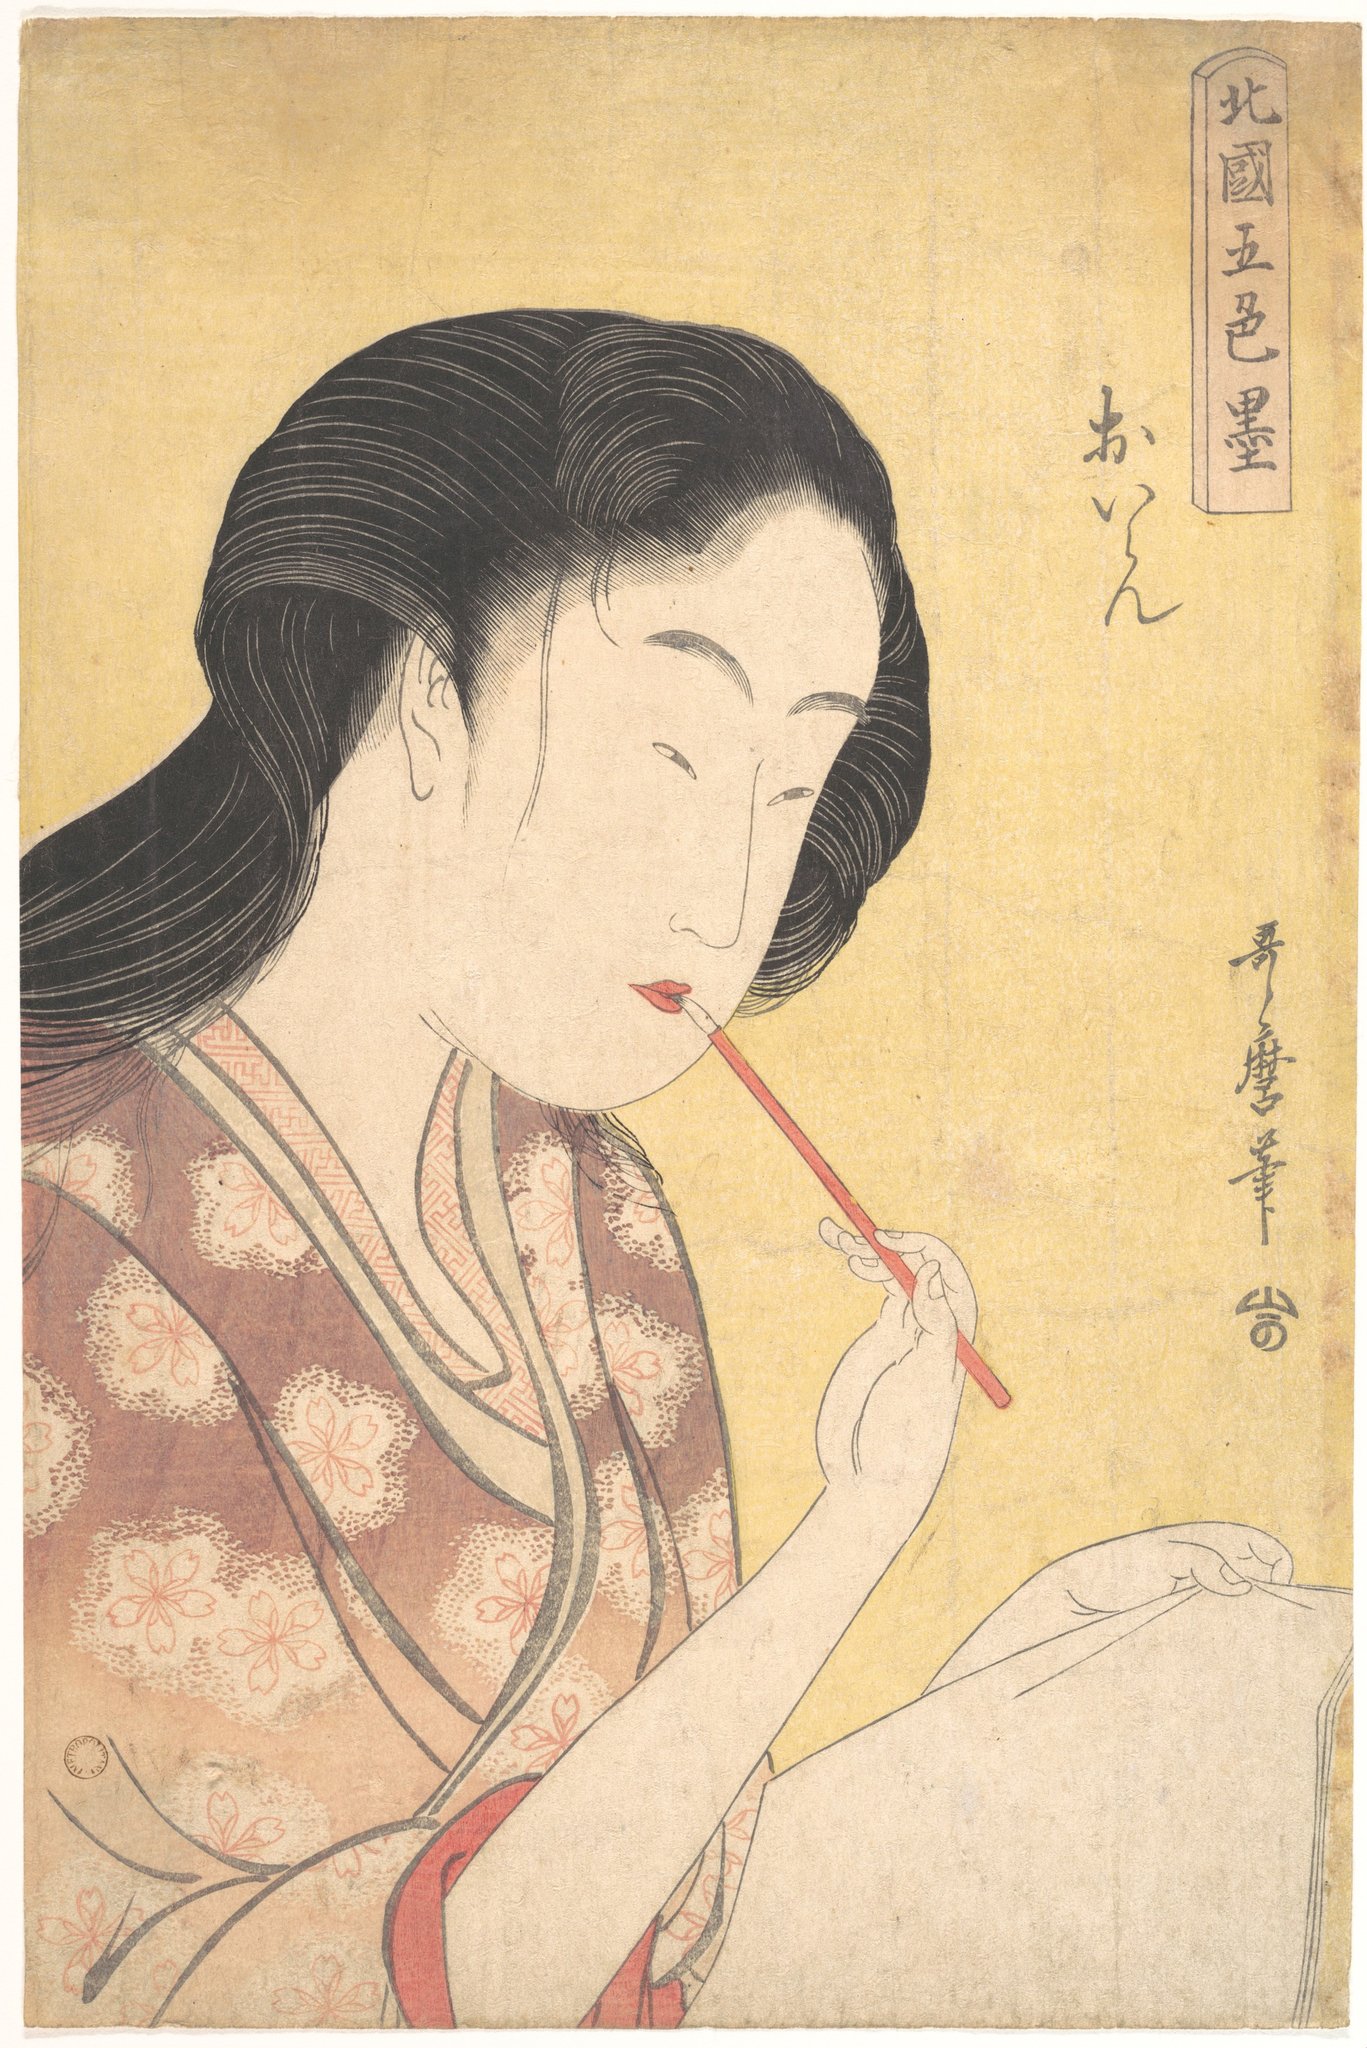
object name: print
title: “High-Ranking Courtesan” (Oiran), from the series Five Shades of Ink in the Northern Quarter (Hokkoku goshiki-zumi),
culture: japanese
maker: kitagawa utamaro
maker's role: artist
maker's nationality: japanese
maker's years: 1754-1806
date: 1794-1795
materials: ink, paper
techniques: woodblock print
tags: women